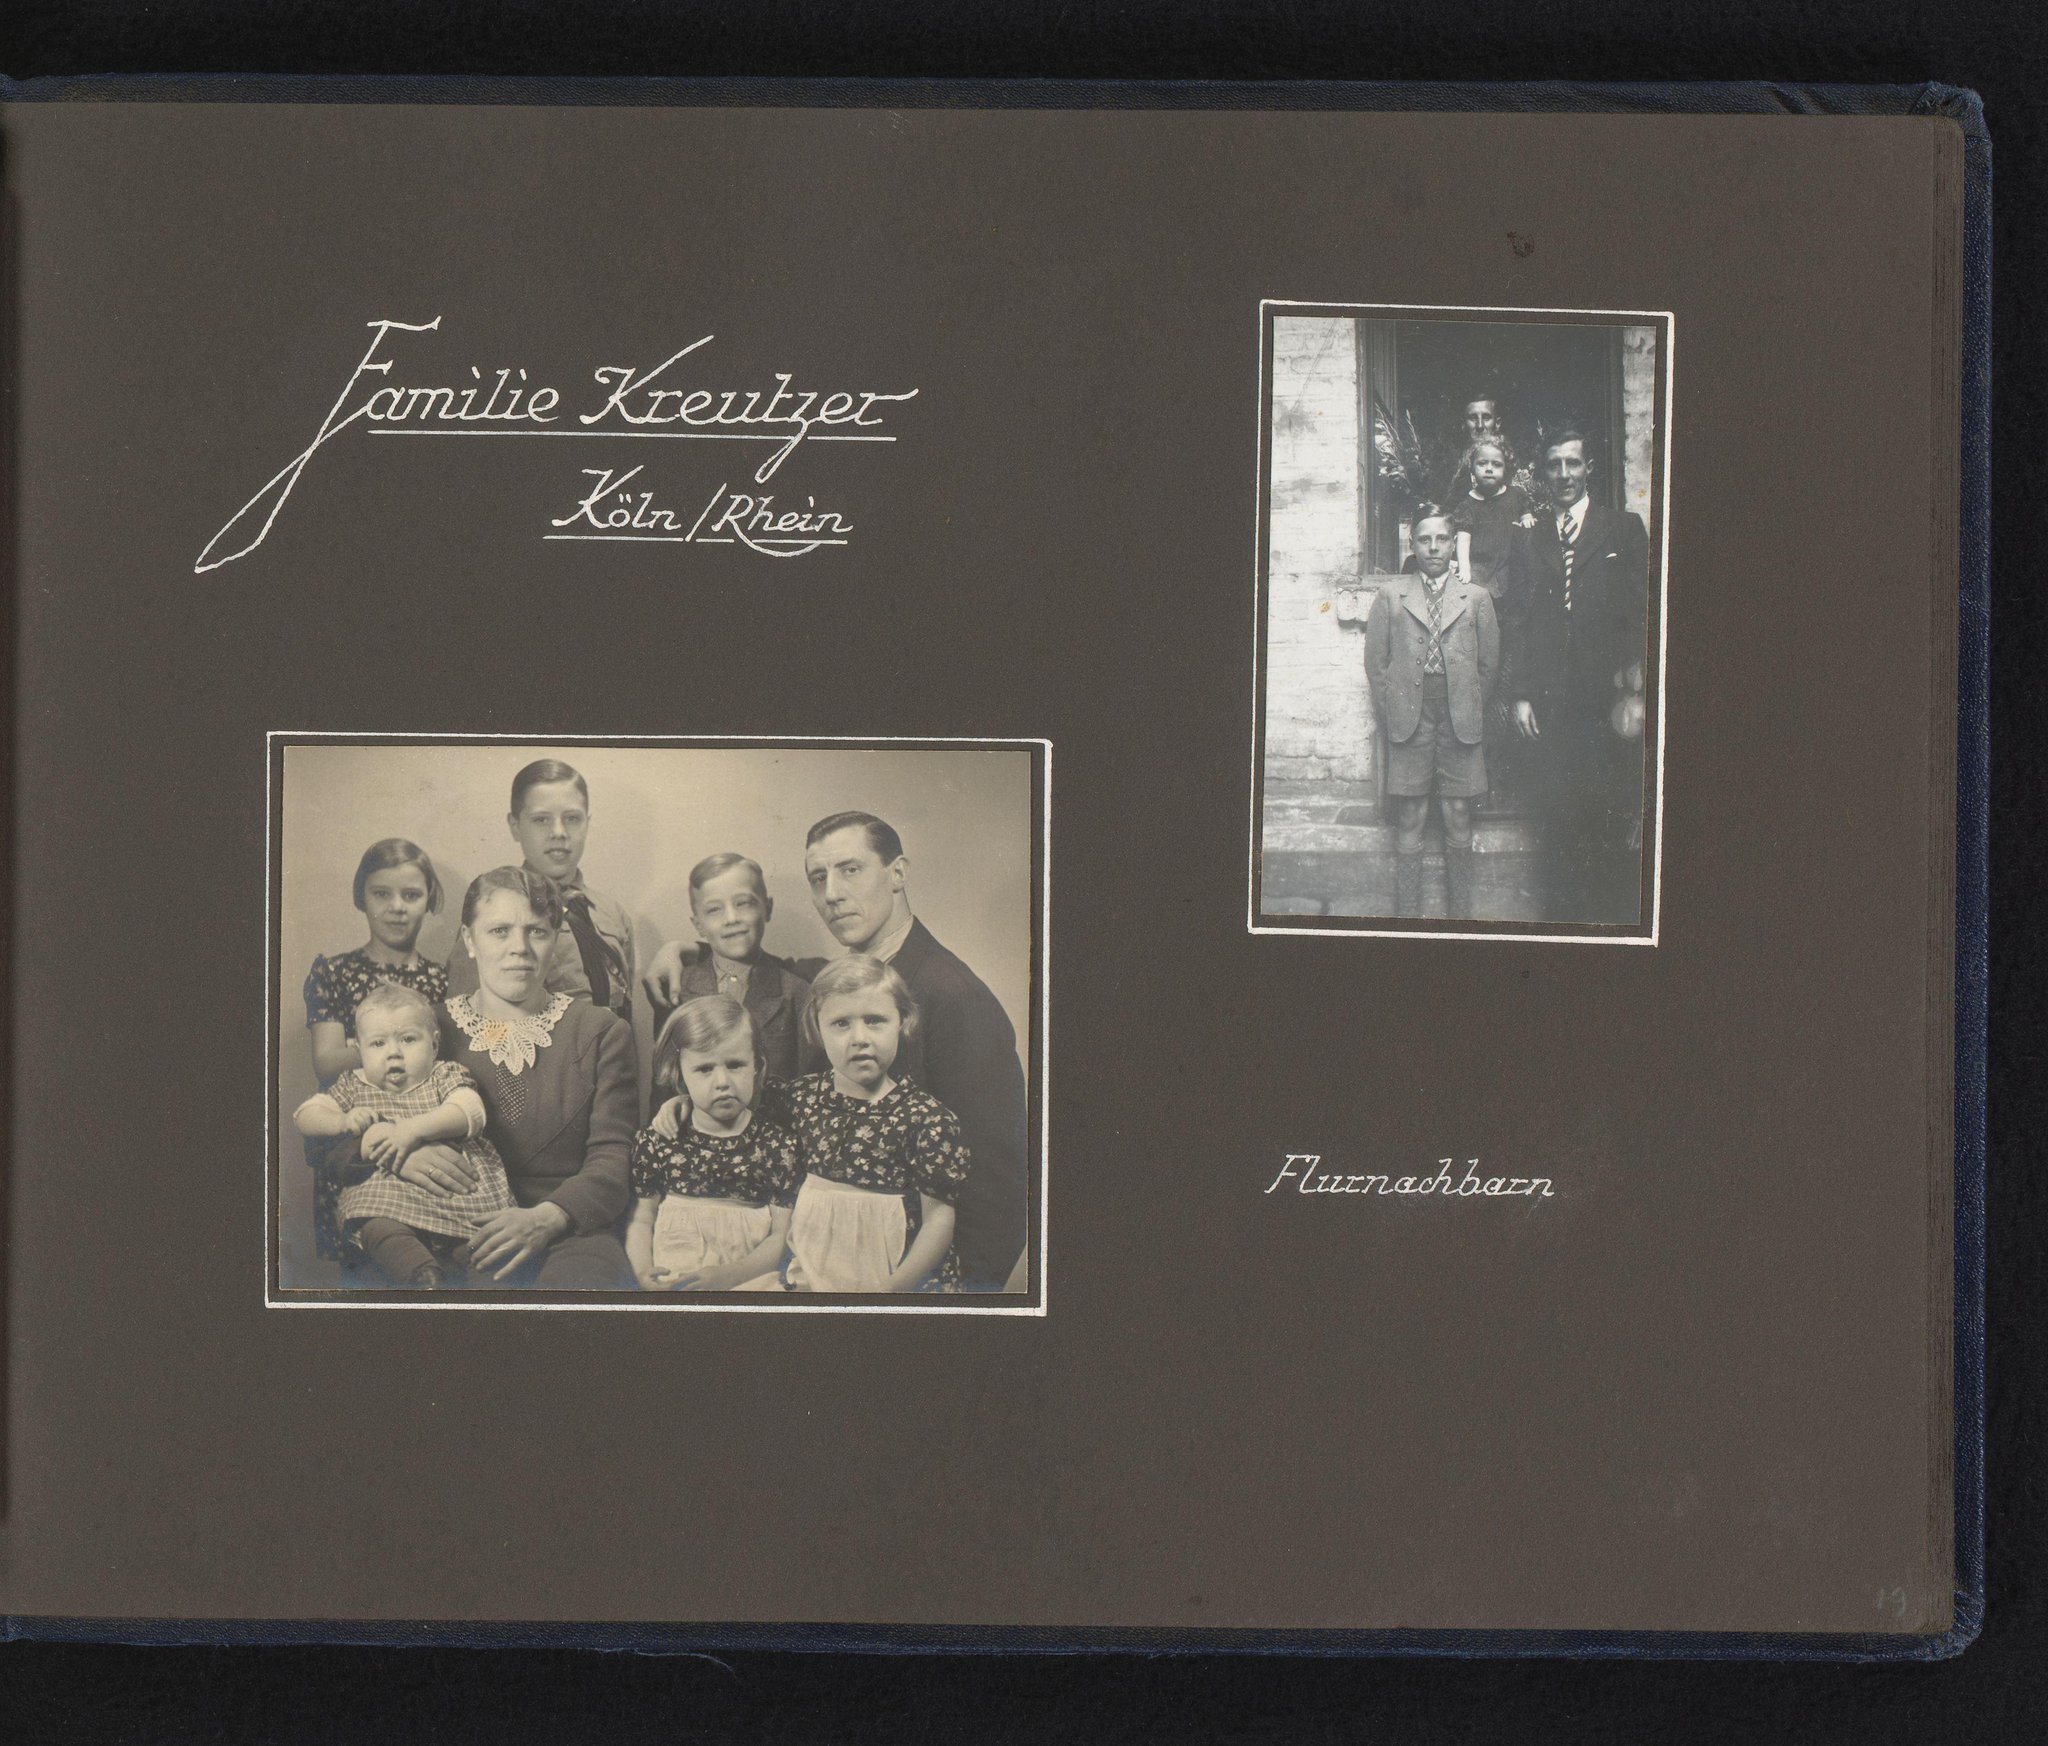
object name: album leaf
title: Buren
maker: Anonymous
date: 1939-1940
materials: paper, photographic support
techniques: gelatin silver print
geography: cologne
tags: neighbour, germany, cologne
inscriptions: inscription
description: Albumblad met twee foto's in de buren in Keulen, ca. 1939-1940. Onderdeel van een Duits militair album Tweede Wereldoorlog 1939-1940.